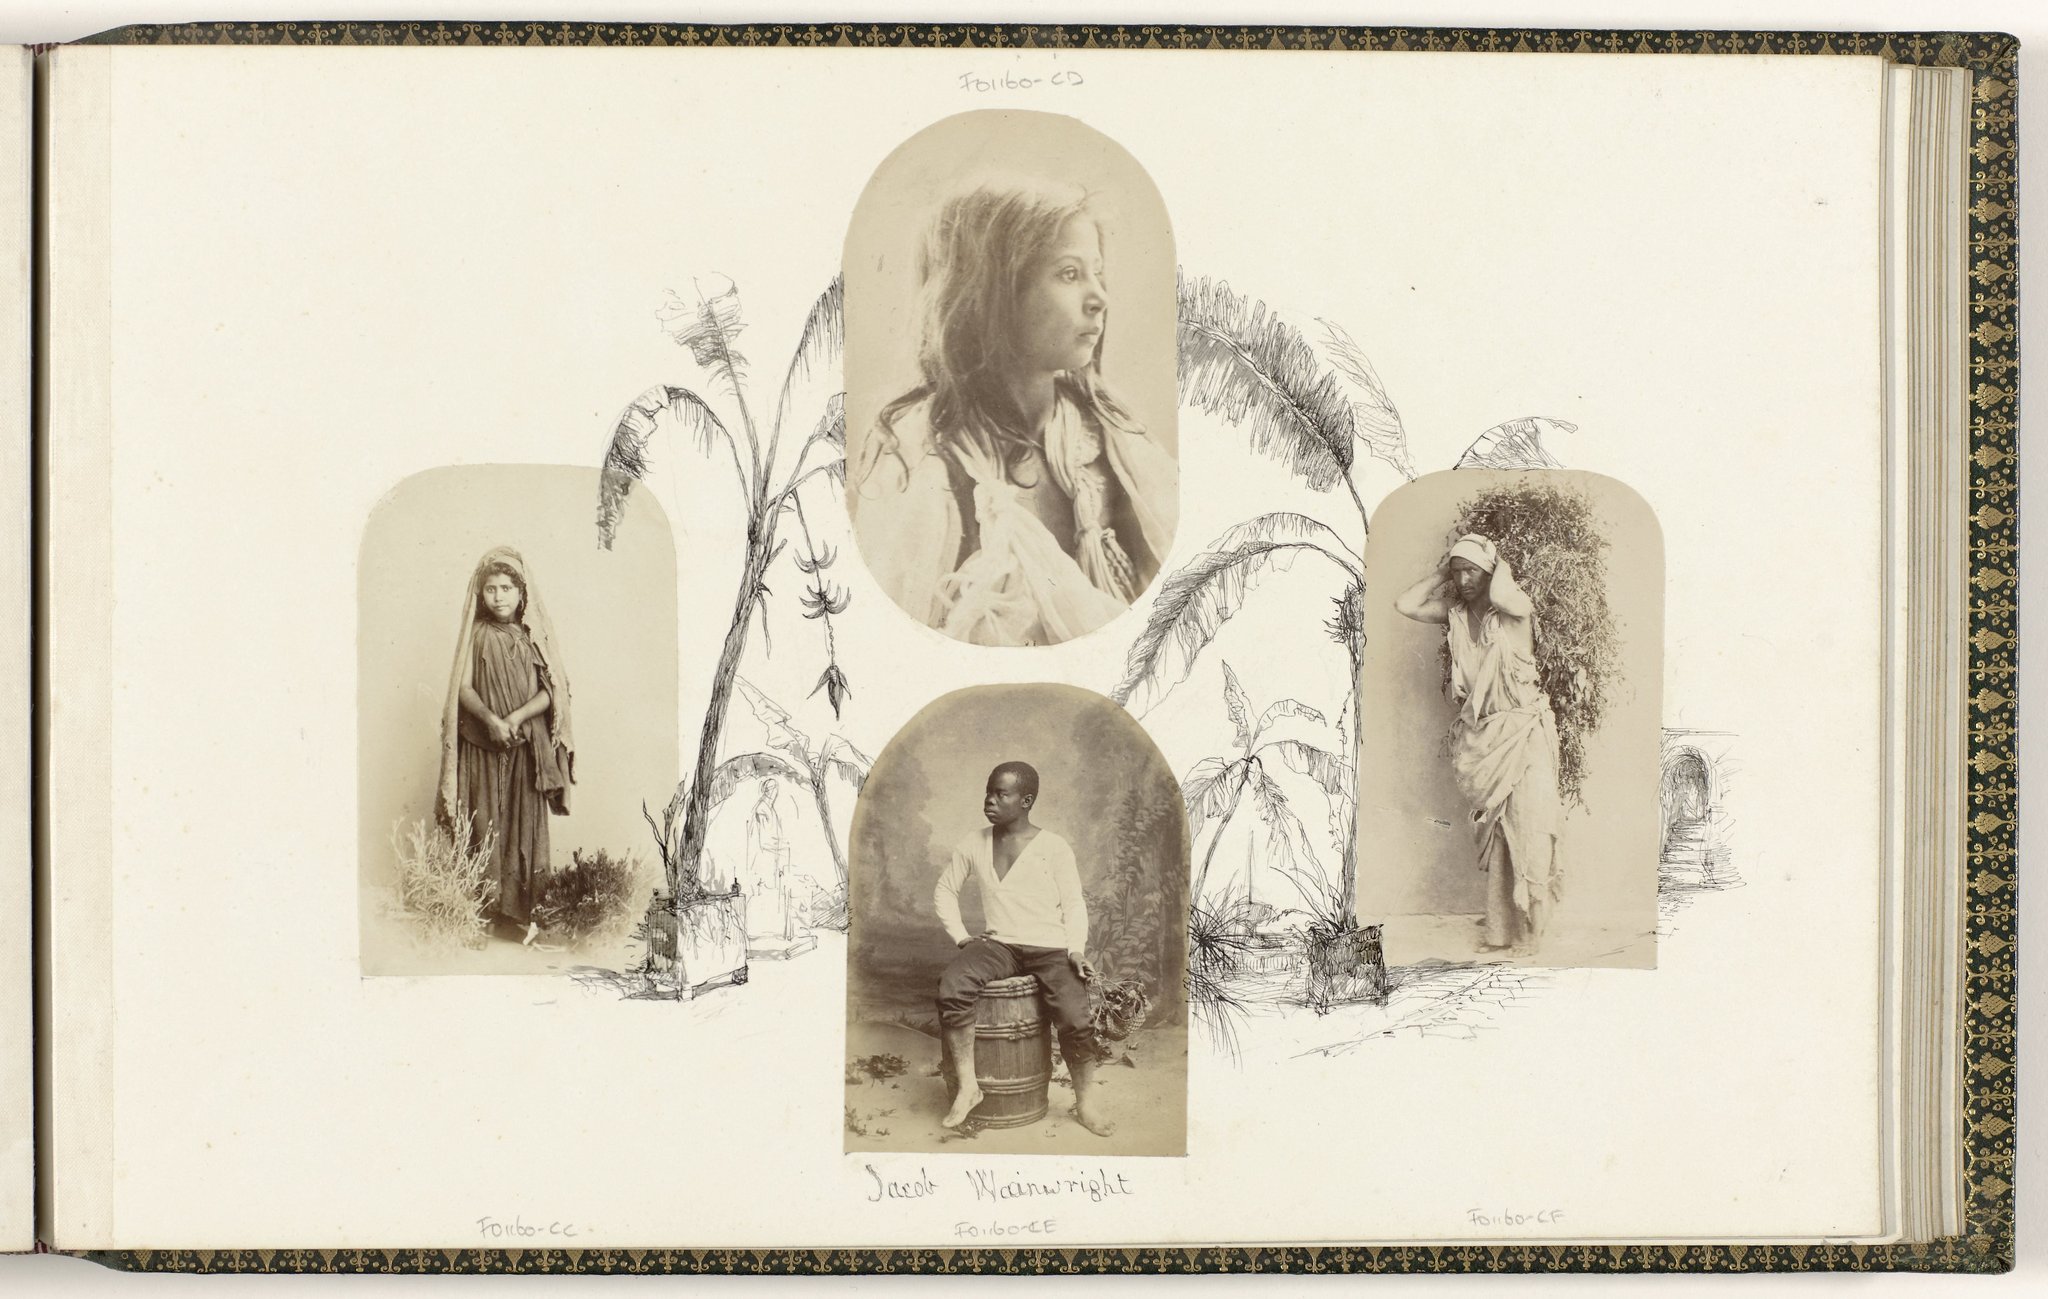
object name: photograph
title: Portret van Jacob Wainwright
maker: Anonymous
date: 1870-1880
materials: paper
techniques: albumen print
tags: africans, historical persons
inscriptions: inscription: ‘Jacob Wainwright’